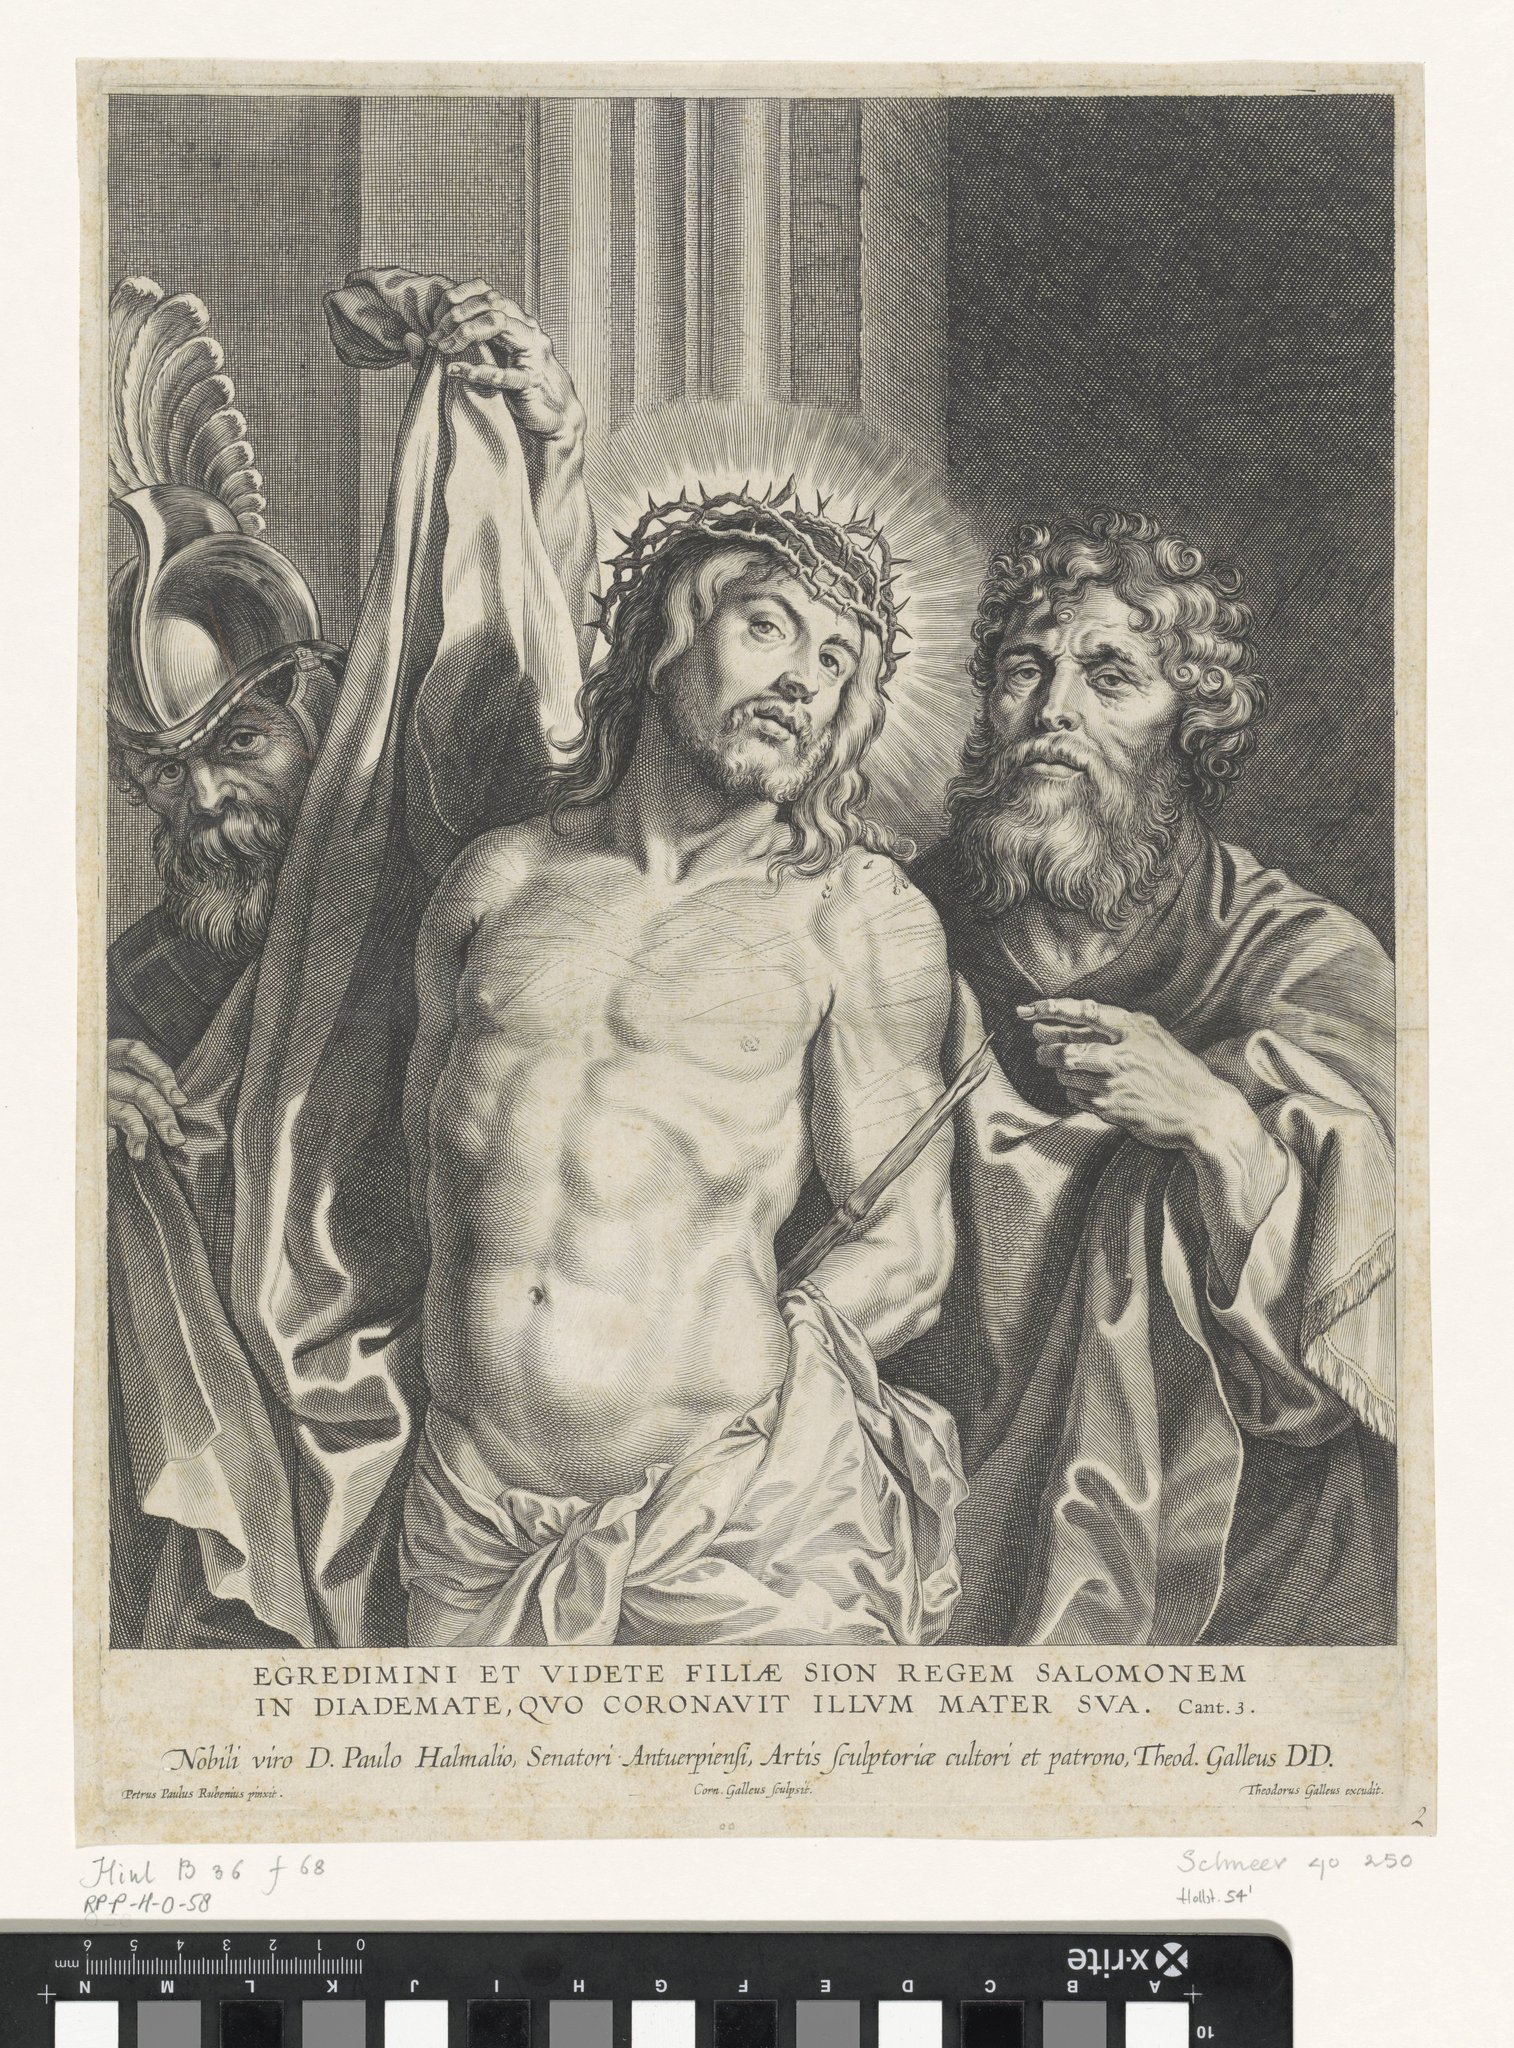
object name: print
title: Christus aan het volk getoond (Ecce Homo)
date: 1586-1650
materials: paper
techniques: engraving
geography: antwerp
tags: pilate showing christ to the people, 'ostentatio christi', 'ecce homo' (john 19:4-6)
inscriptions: collector's mark: Lugt 10, collector's mark: Lugt 11, number: ‘2’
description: Christus met de doornenkroon wordt door twee soldaten aan het volk getoond. Onder de voorstelling een bijbelvers uit Hoogl. 3 in het Latijn.